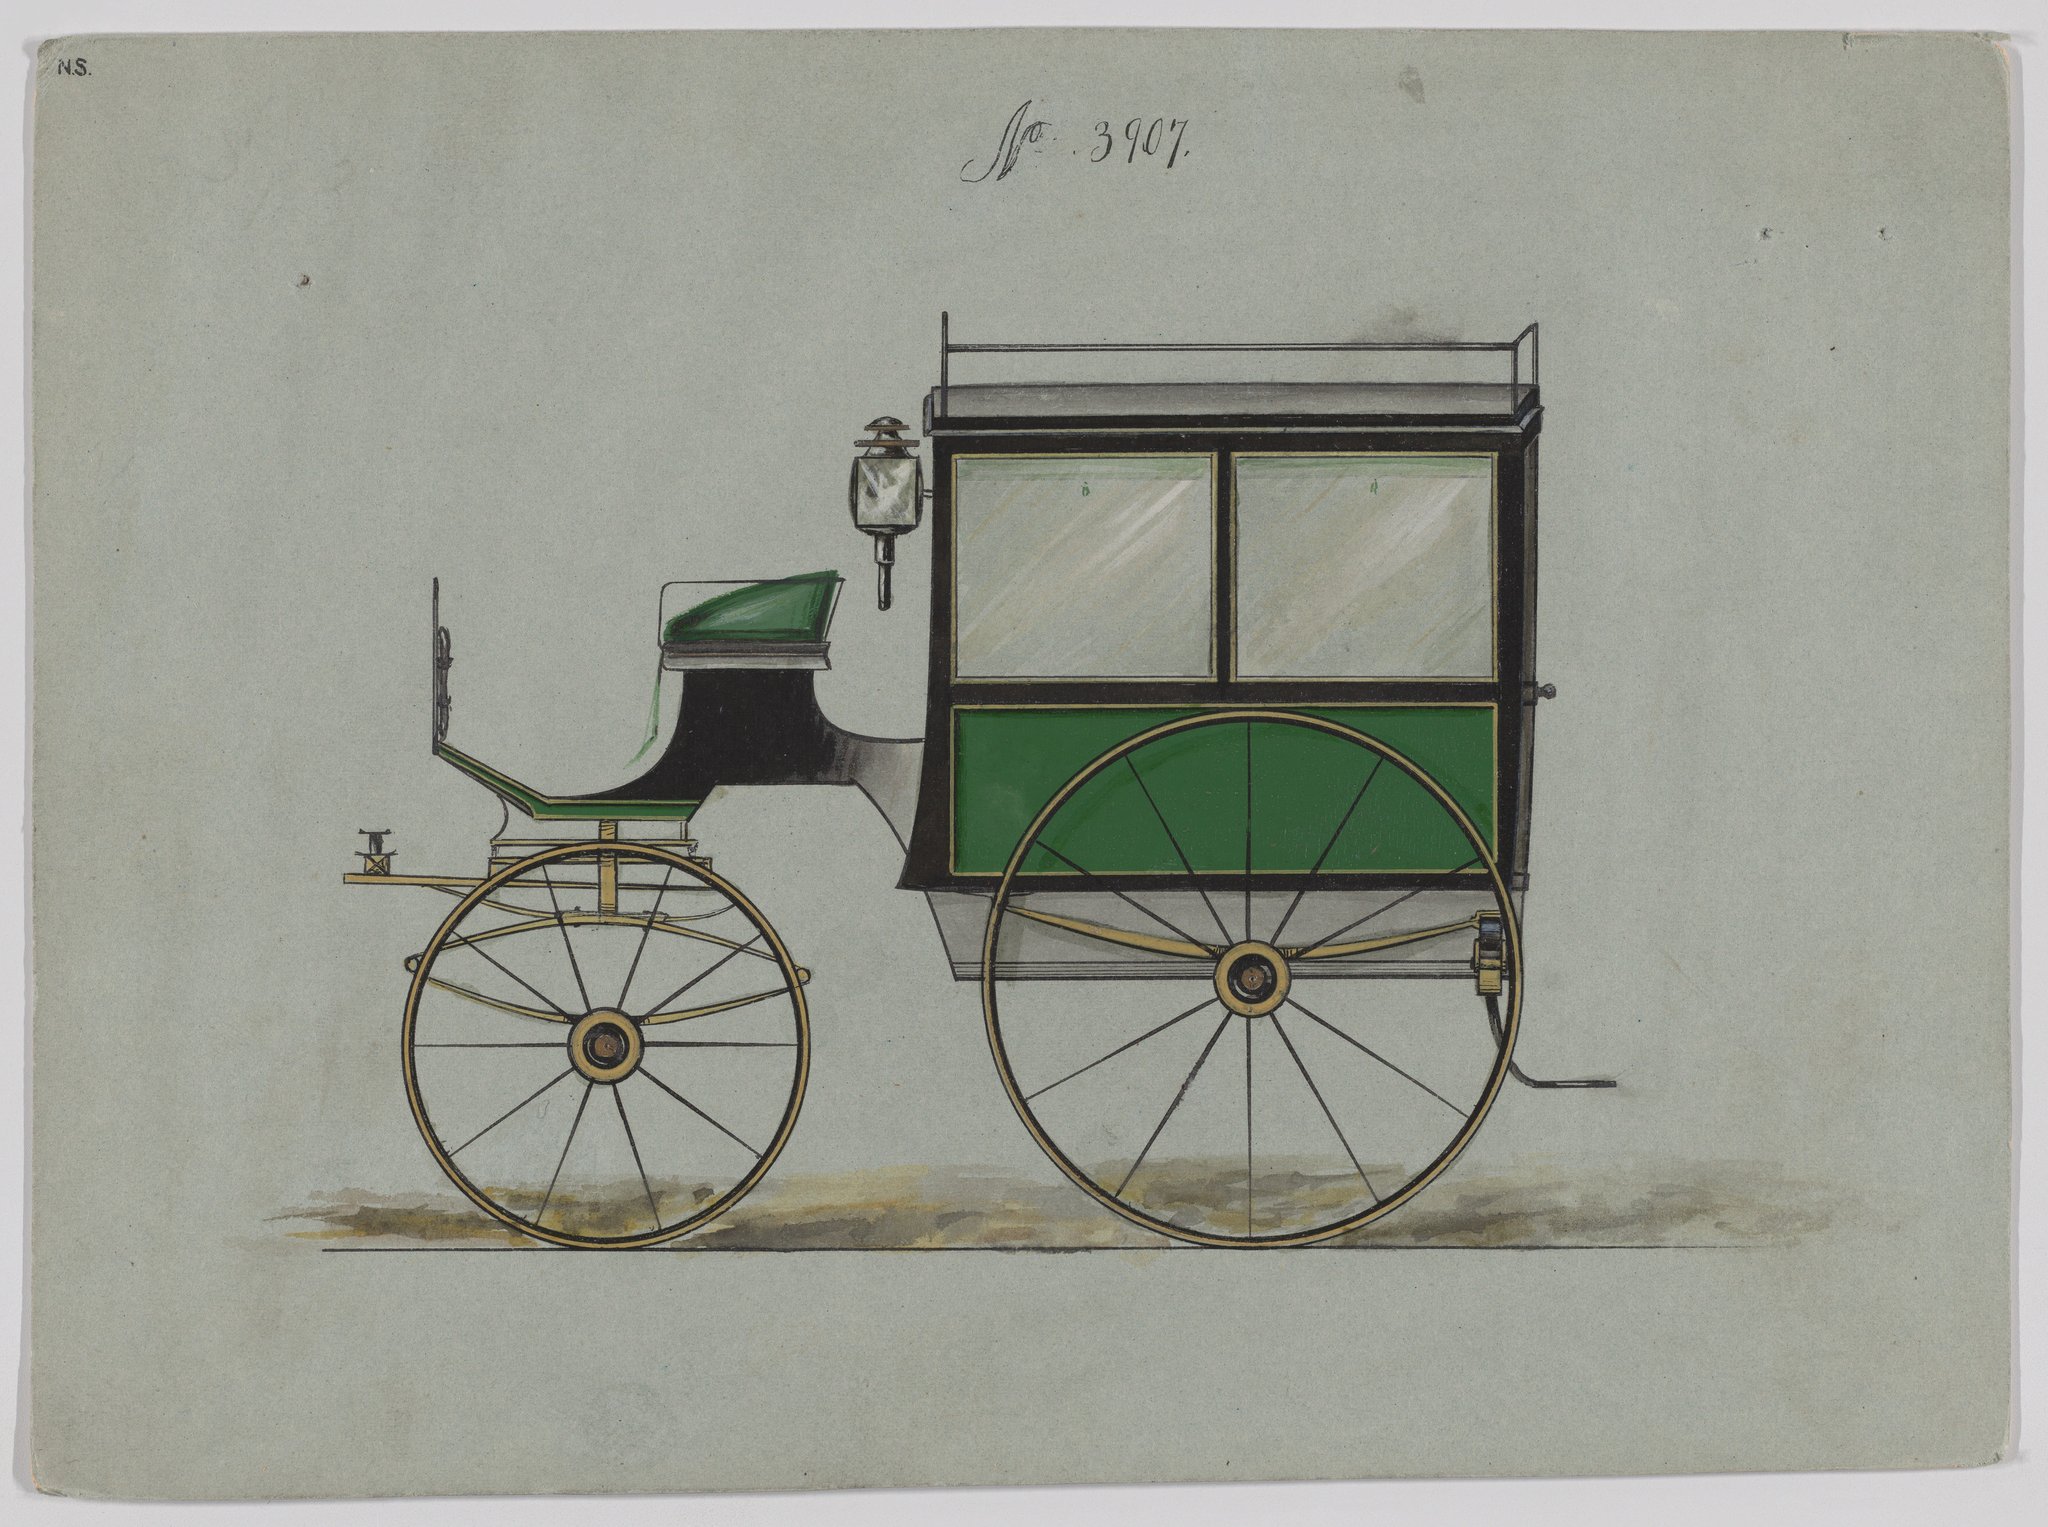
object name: drawing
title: Design for Omnibus or Wagonette, no. 3907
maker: brewster & co.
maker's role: manufacturer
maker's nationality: american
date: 1884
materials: ink, watercolor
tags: carriages